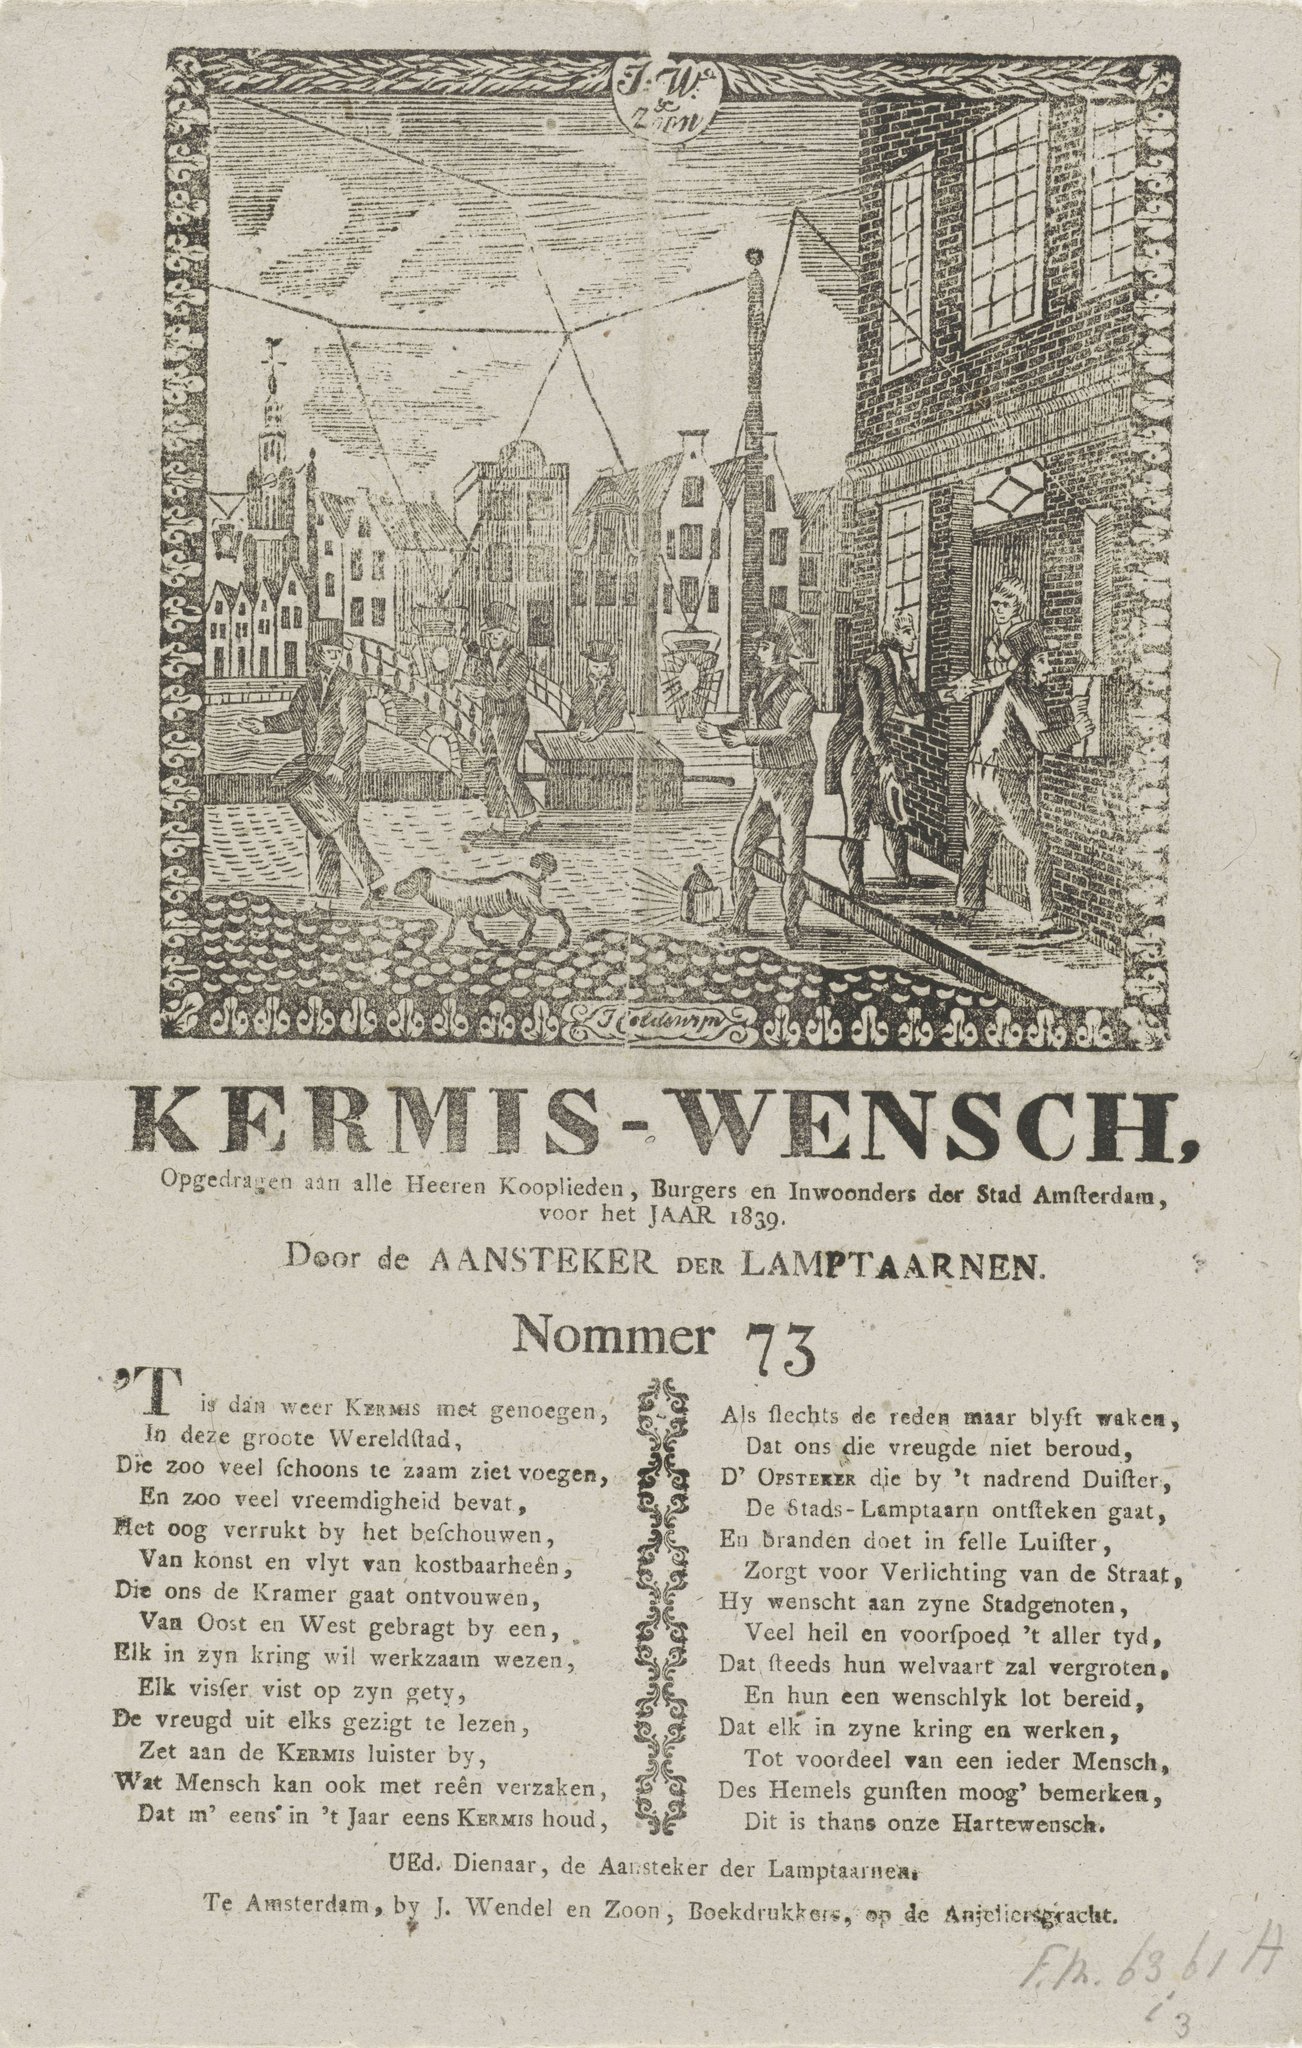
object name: print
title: Kermis-wensch (...) door de Aansteker der Lamptaarnen. Nommer 73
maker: jacob coldewijn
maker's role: print maker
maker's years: 1796-1855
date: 1839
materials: paper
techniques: letterpress printing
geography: amsterdam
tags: oil-lamp (+ kindling a light; lit, burning light, lamp, candle), street lighting, street, amsterdam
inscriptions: collector's mark: Lugt 2228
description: Kermisprent van de Amsterdamse lantaarnopstekers en vullers voor het jaar 1839. Gezicht in een straat in Amsterdam waar enkele mannen bezig zijn de straatlantaarns te vullen en aan te steken. Een andere man haalt geld op bij een huis. Met gedicht in twee kolommen. Van de lantaarnopstekers in wijk no. 73.